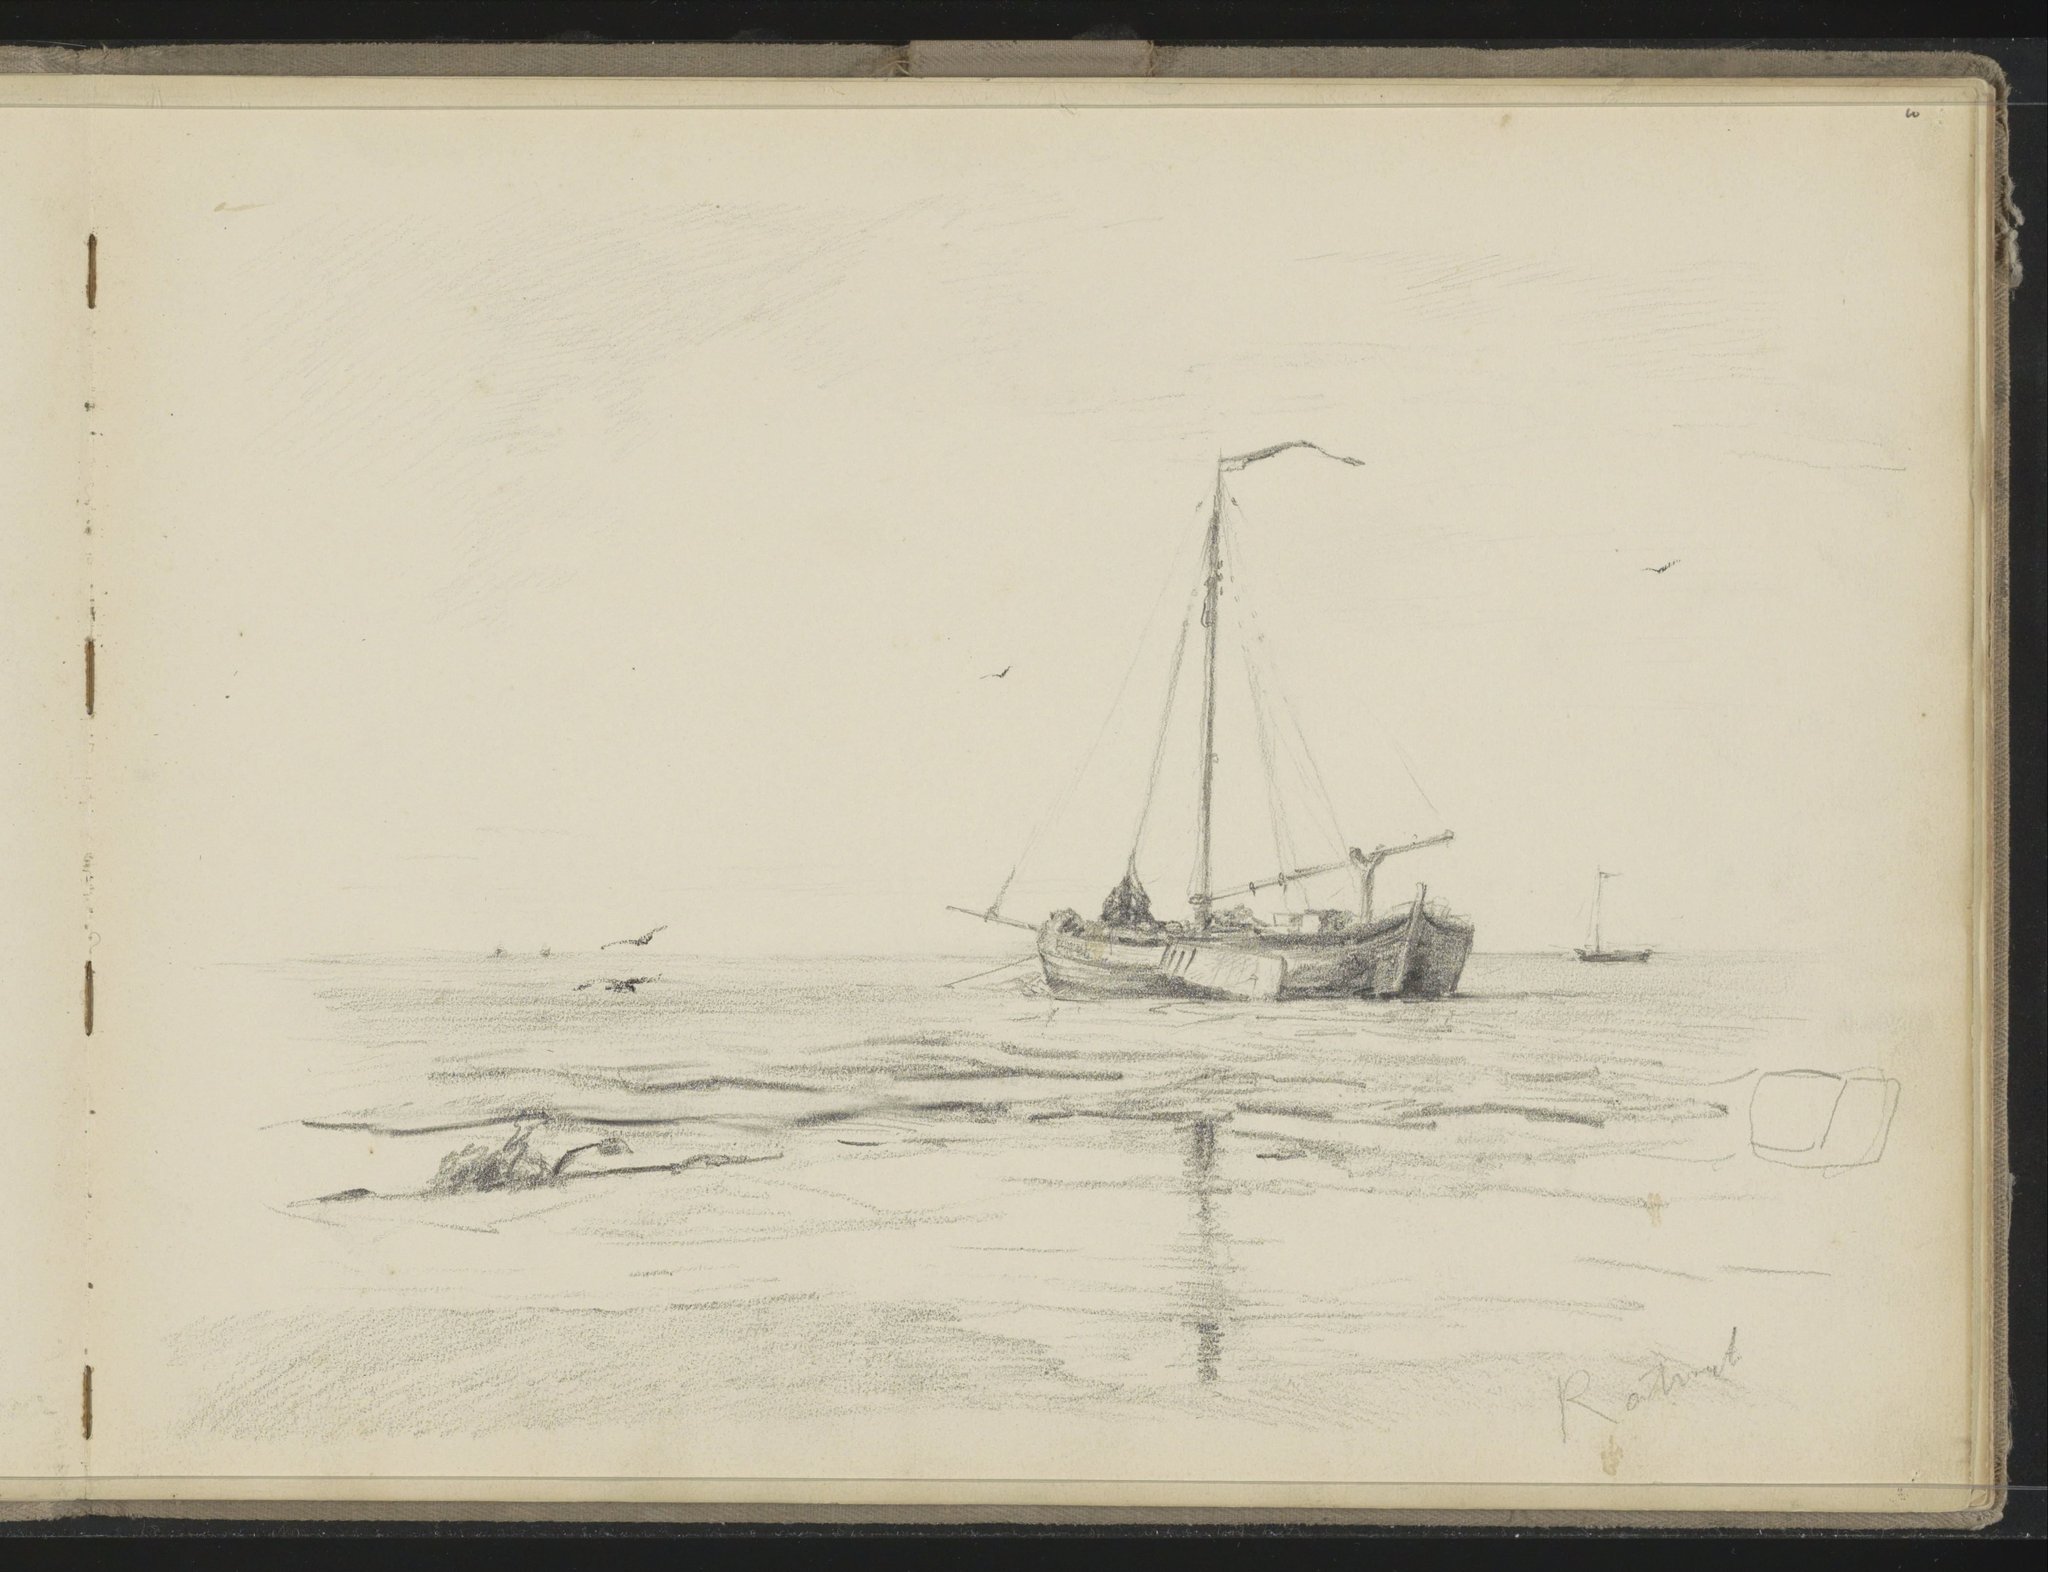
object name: sketchbook leaf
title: Vissersboot voor de kust van Katwijk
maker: chris huidekooper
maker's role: draughtsman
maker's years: 1878-1939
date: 1895-1896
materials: paper, pencil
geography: katwijk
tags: sailing-ship, sailing-boat, coast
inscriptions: annotation: ‘Katwijk’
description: Blad 10 recto uit een schetsboek met 32 bladen.